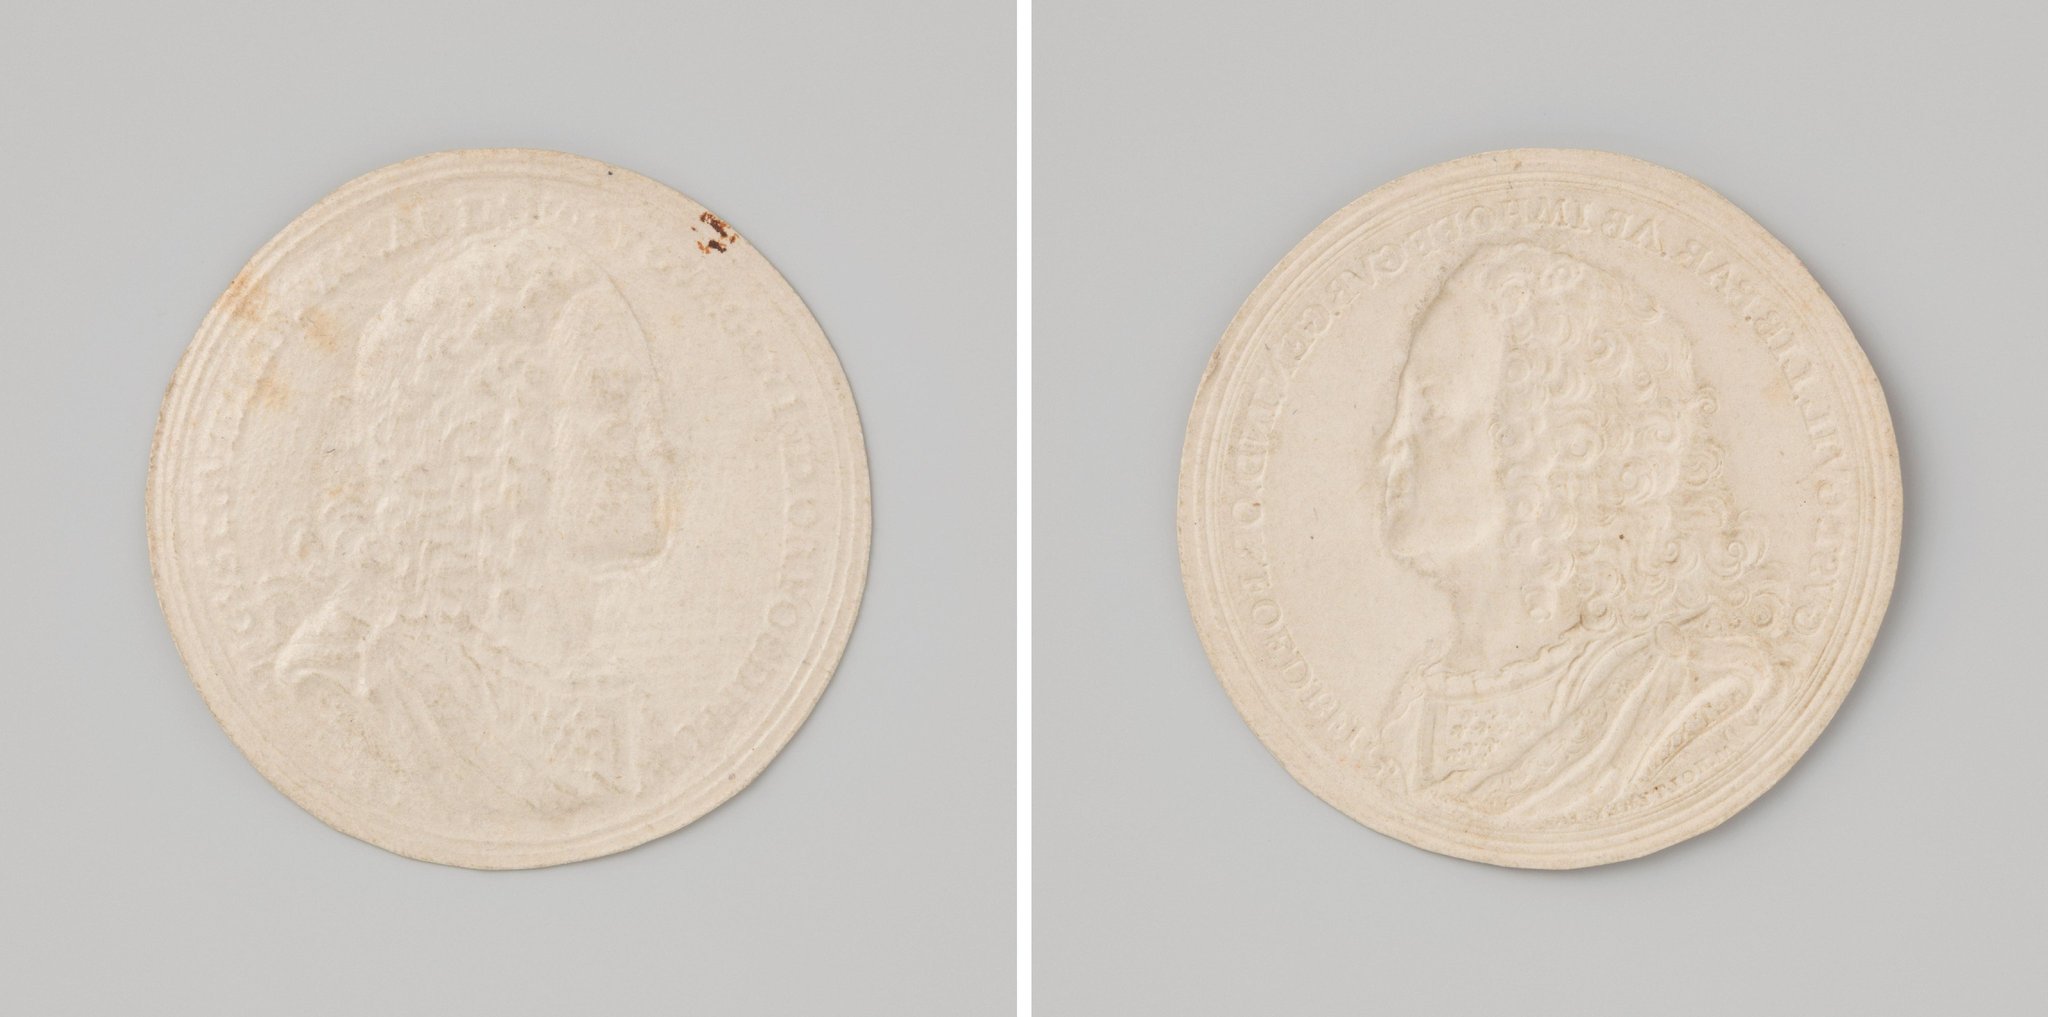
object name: history medal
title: Vertrek van baron Van Imhoff, gouverneur van Nederlands Oost Indië 1742, afdruk voorzijde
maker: martinus holtzhey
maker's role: medailleur, muntmaker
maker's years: 1697-1764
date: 1742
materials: cardboard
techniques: pressing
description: Afdruk in karton van de voorzijde van de penning, waarop het borstbeeld van Van Imhoff naar rechts met omschrift.